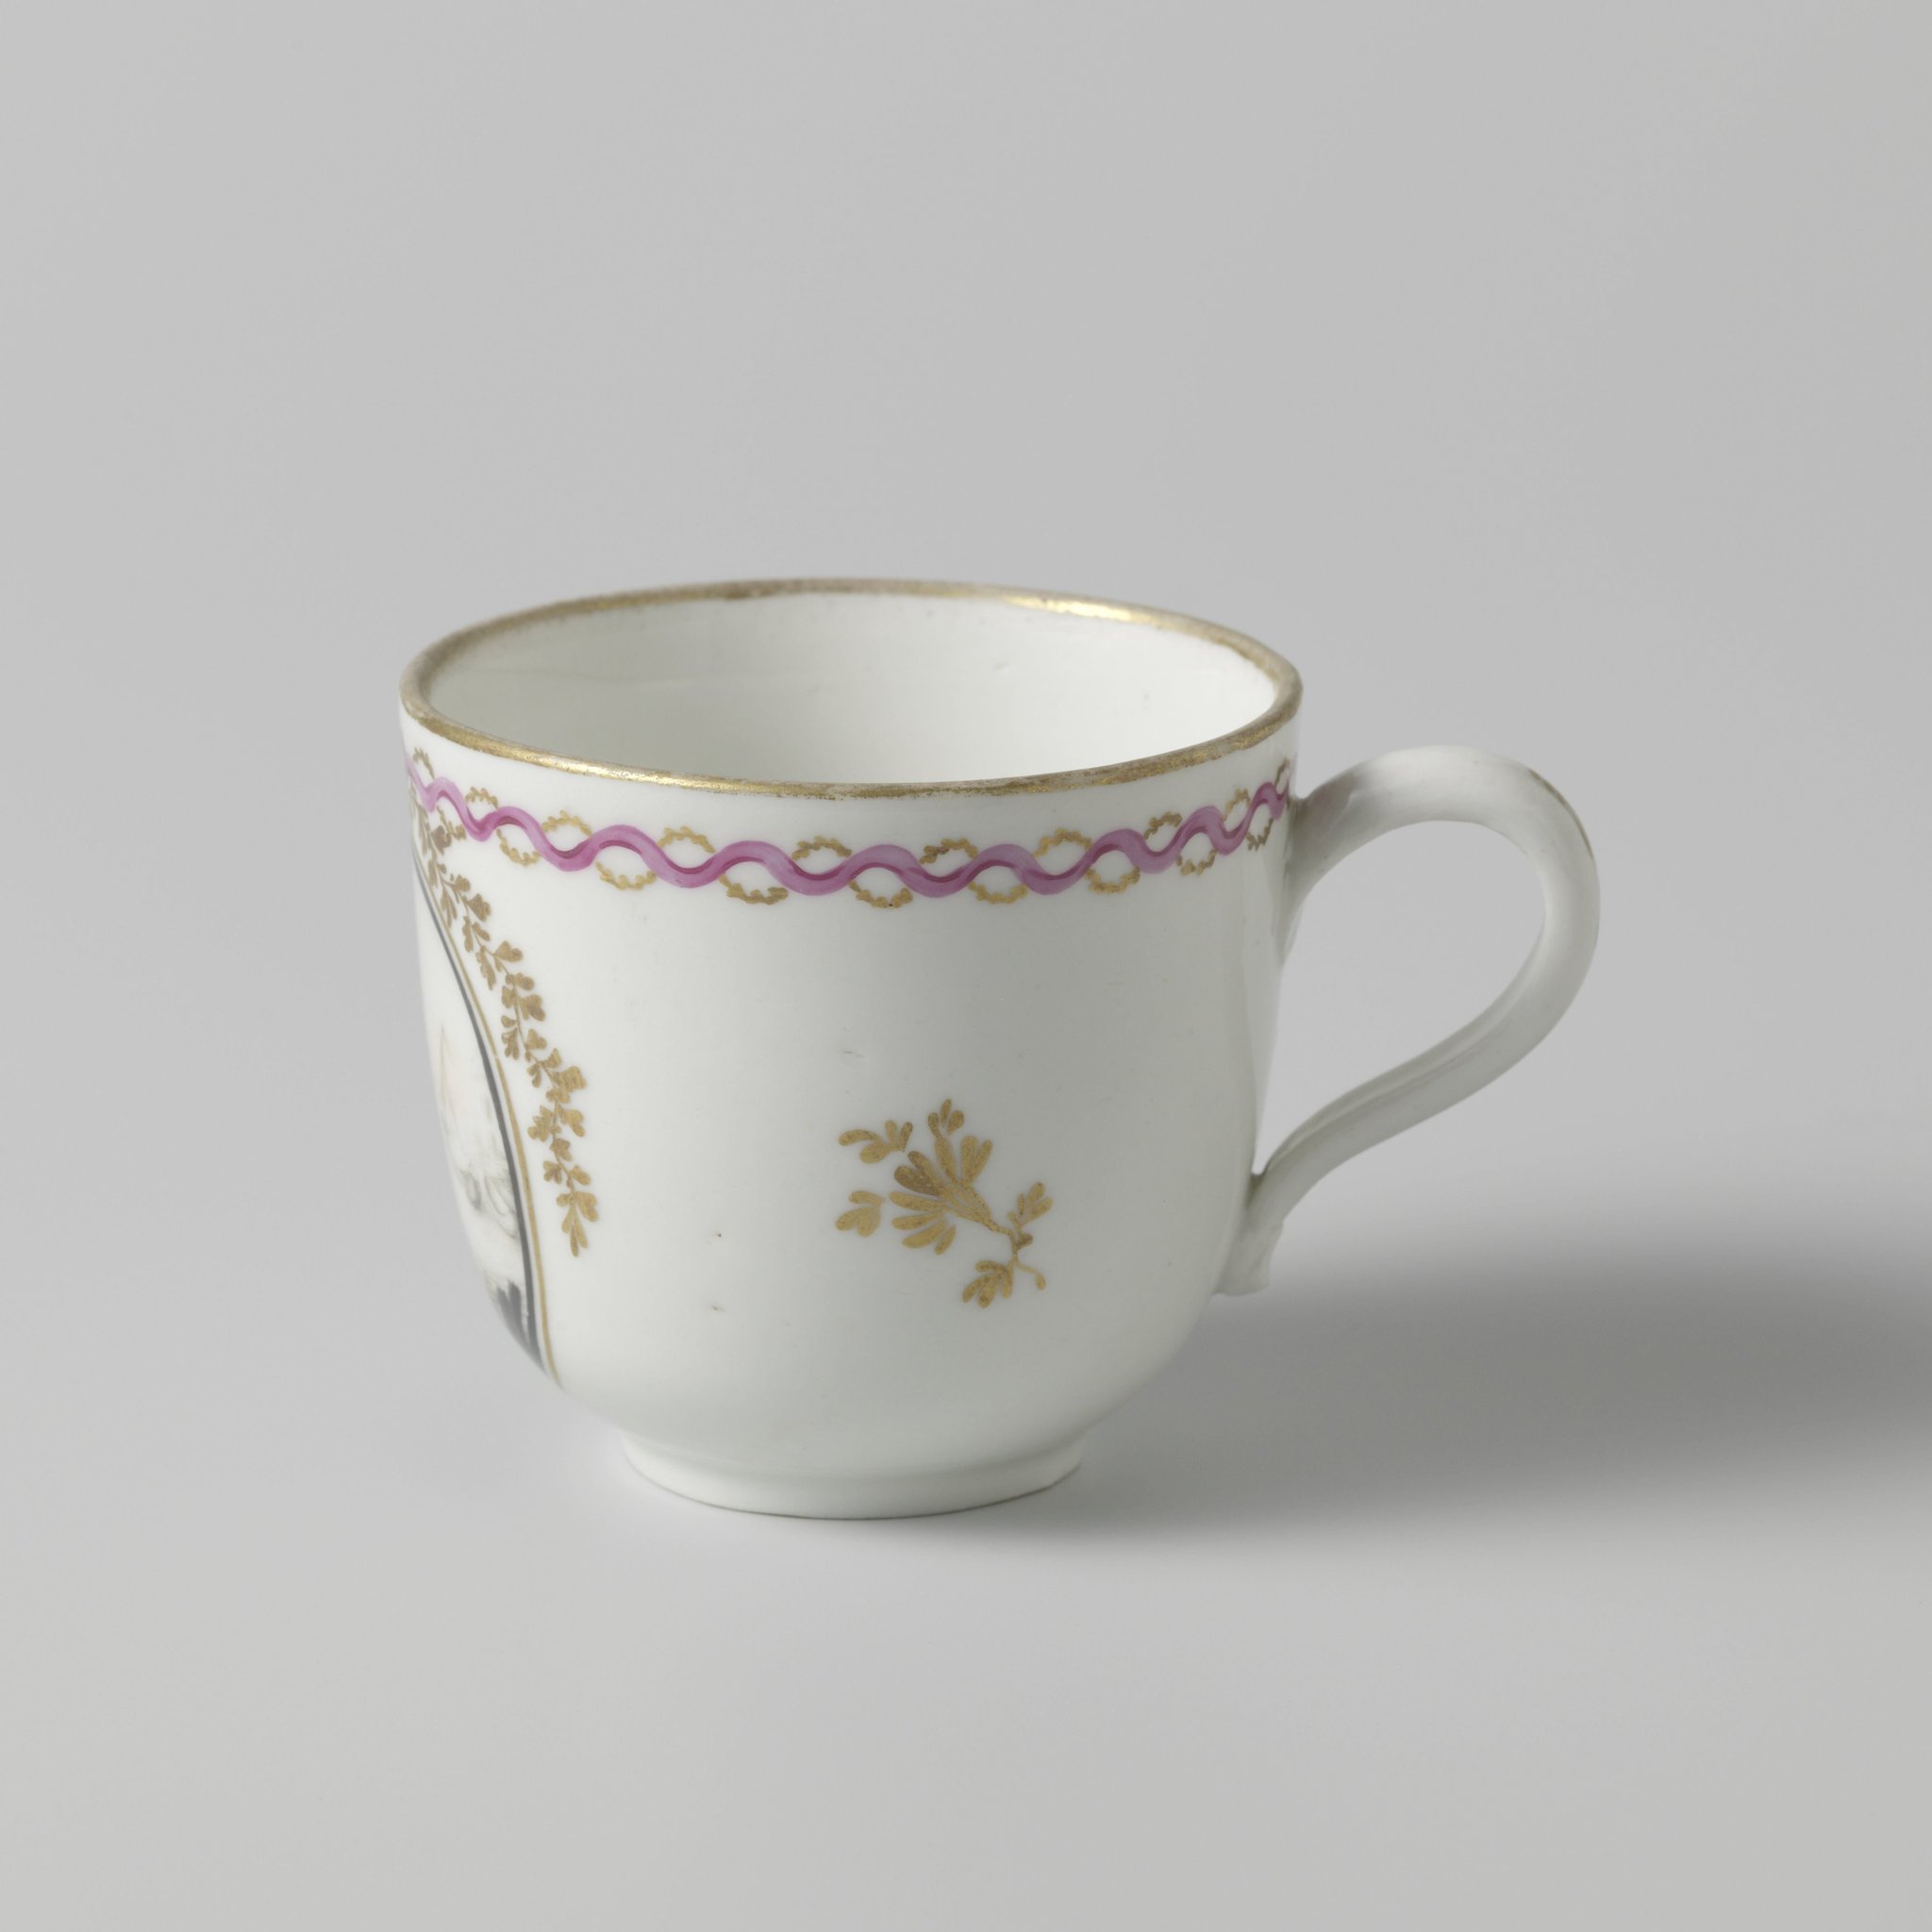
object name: cup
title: Cup with a woman and a fisherman on the coast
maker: Anonymous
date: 1790-1800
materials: glaze, gold, paint, porcelain, soft paste porcelain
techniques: firing, forming, gilding, turning, vitrification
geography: europe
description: Kop van soft-paste porselein (pâte-tendre) met een C-vormig oor, beschilderd op het glazuur in rood, roze, zwart en goud. Op de buitenwand een medaillon met daarin een vrouw en een visser aan de kust, kijkend naar de boten op het water. Boven het medaillon een guirlande en aan weerszijden ervan een bloemtak. Op de buitenrand een golvende band van een lint en een bladrank die elkaar kruisen. Bladmotieven op het oor. Gouden rand.